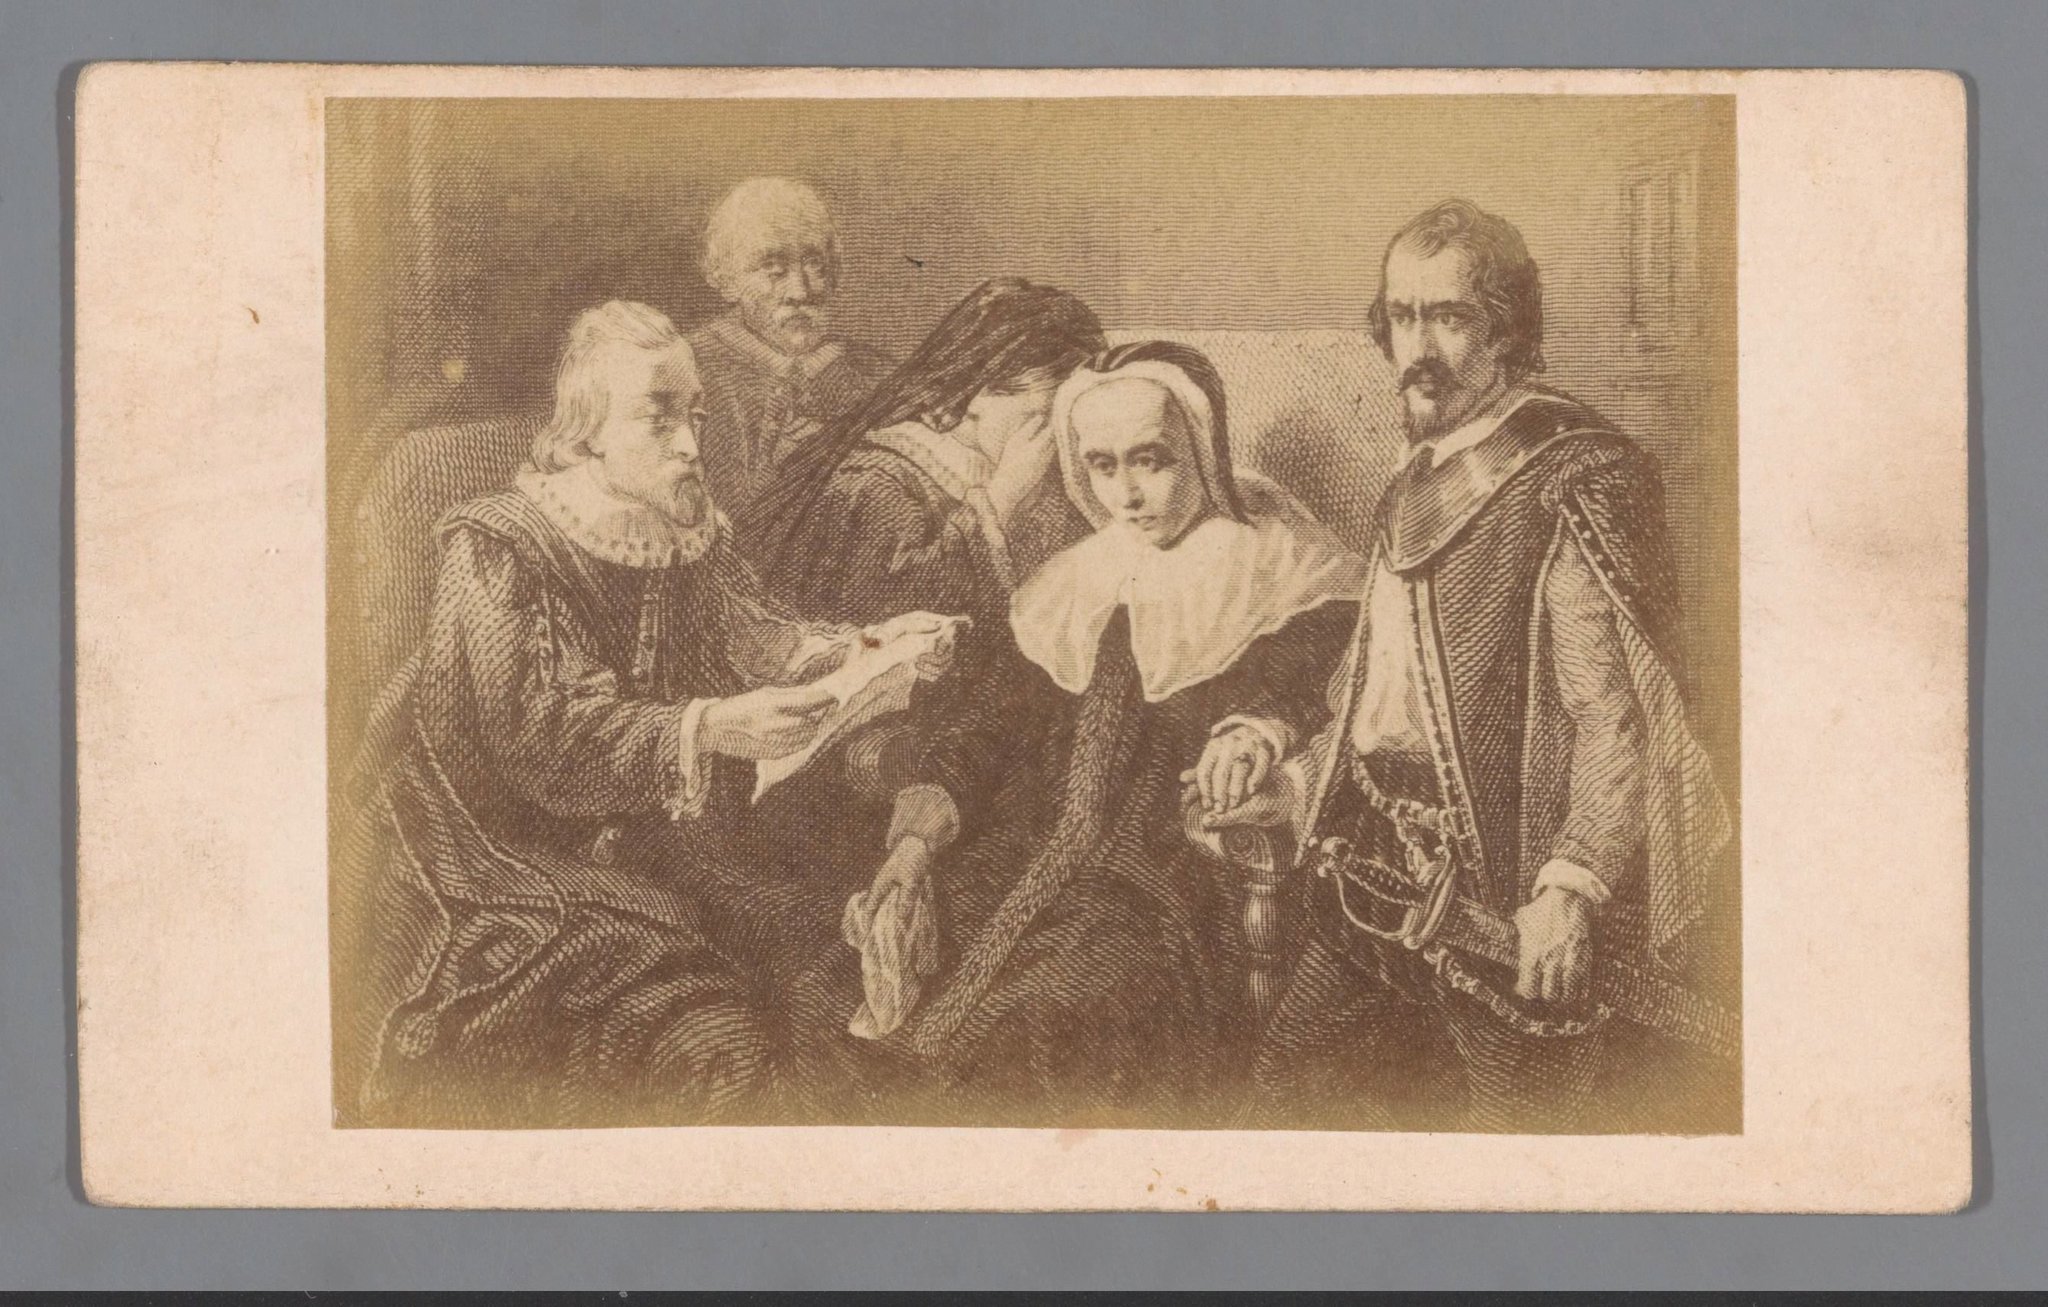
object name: carte de visite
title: Photo Reproduction of an Engraving after a Painting by Jozef Israëls of the Johan van Oldenbarnevelt Family Reading his Farewell Letter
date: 1850-1900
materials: cardboard, photographic support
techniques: albumen print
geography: netherlands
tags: reading, netherlands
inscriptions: number: ‘44’, inscription: ‘Oldenbarnevelds Afscheidsbrief (...) Jozef Israels.’, number: ‘44’